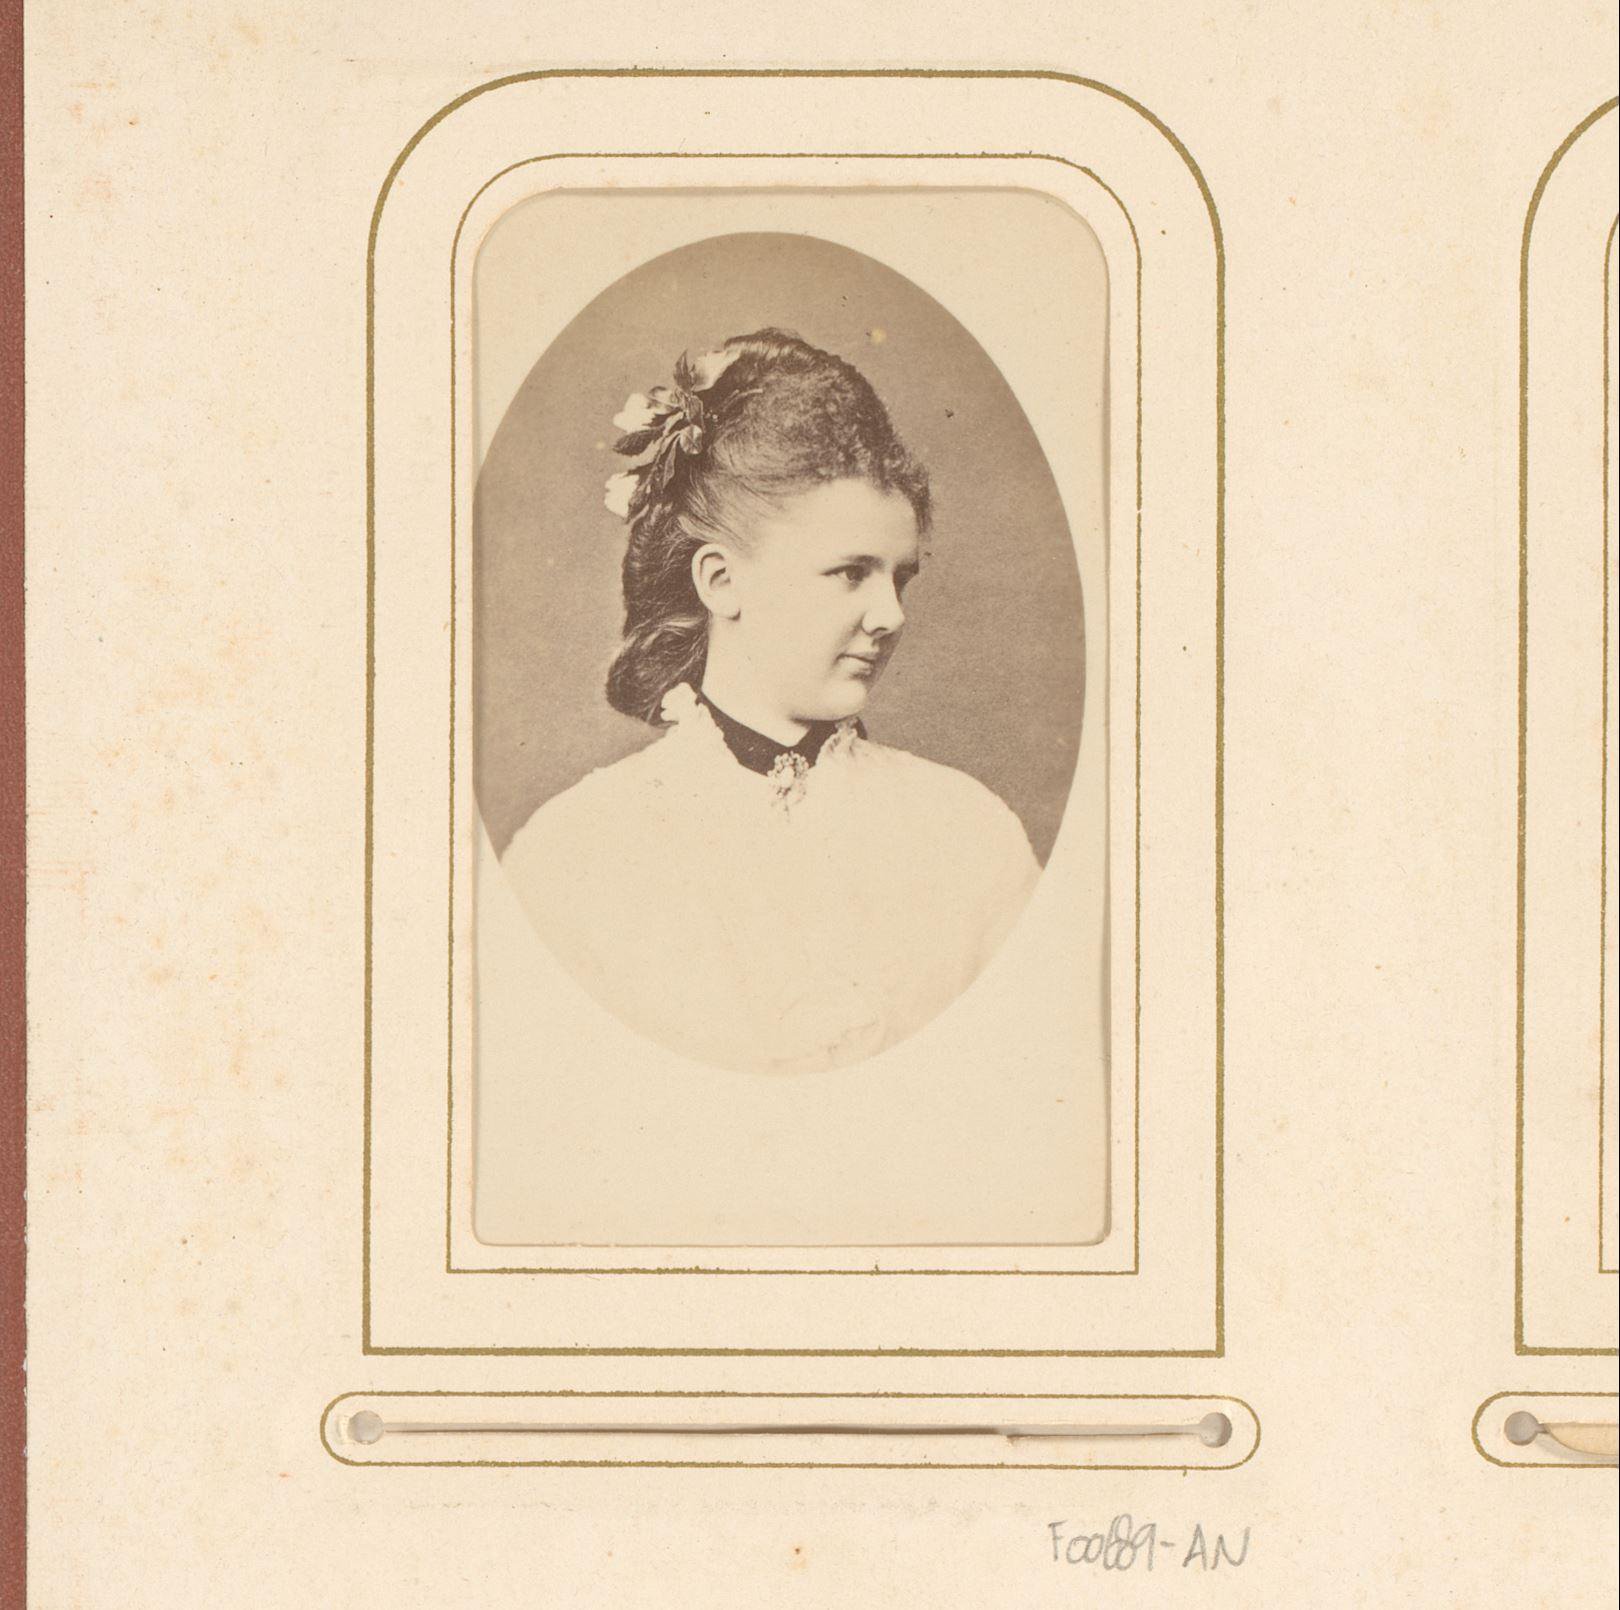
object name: photograph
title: Portret van Emma, koningin-regentes der Nederlanden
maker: Anonymous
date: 1870-1890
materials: cardboard, photographic support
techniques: albumen print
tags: the hague, emma (queen consort of the netherlands), historical persons - bb - woman, ruler, sovereign - bb - female ruler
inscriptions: retailer's mark: ‘Algemeene boekhandel/ A. v Hoogstren & Zoon./ Den Haag’, inscription: ‘H.D.H. prinses Emma van Waldeck-Pyrmont’